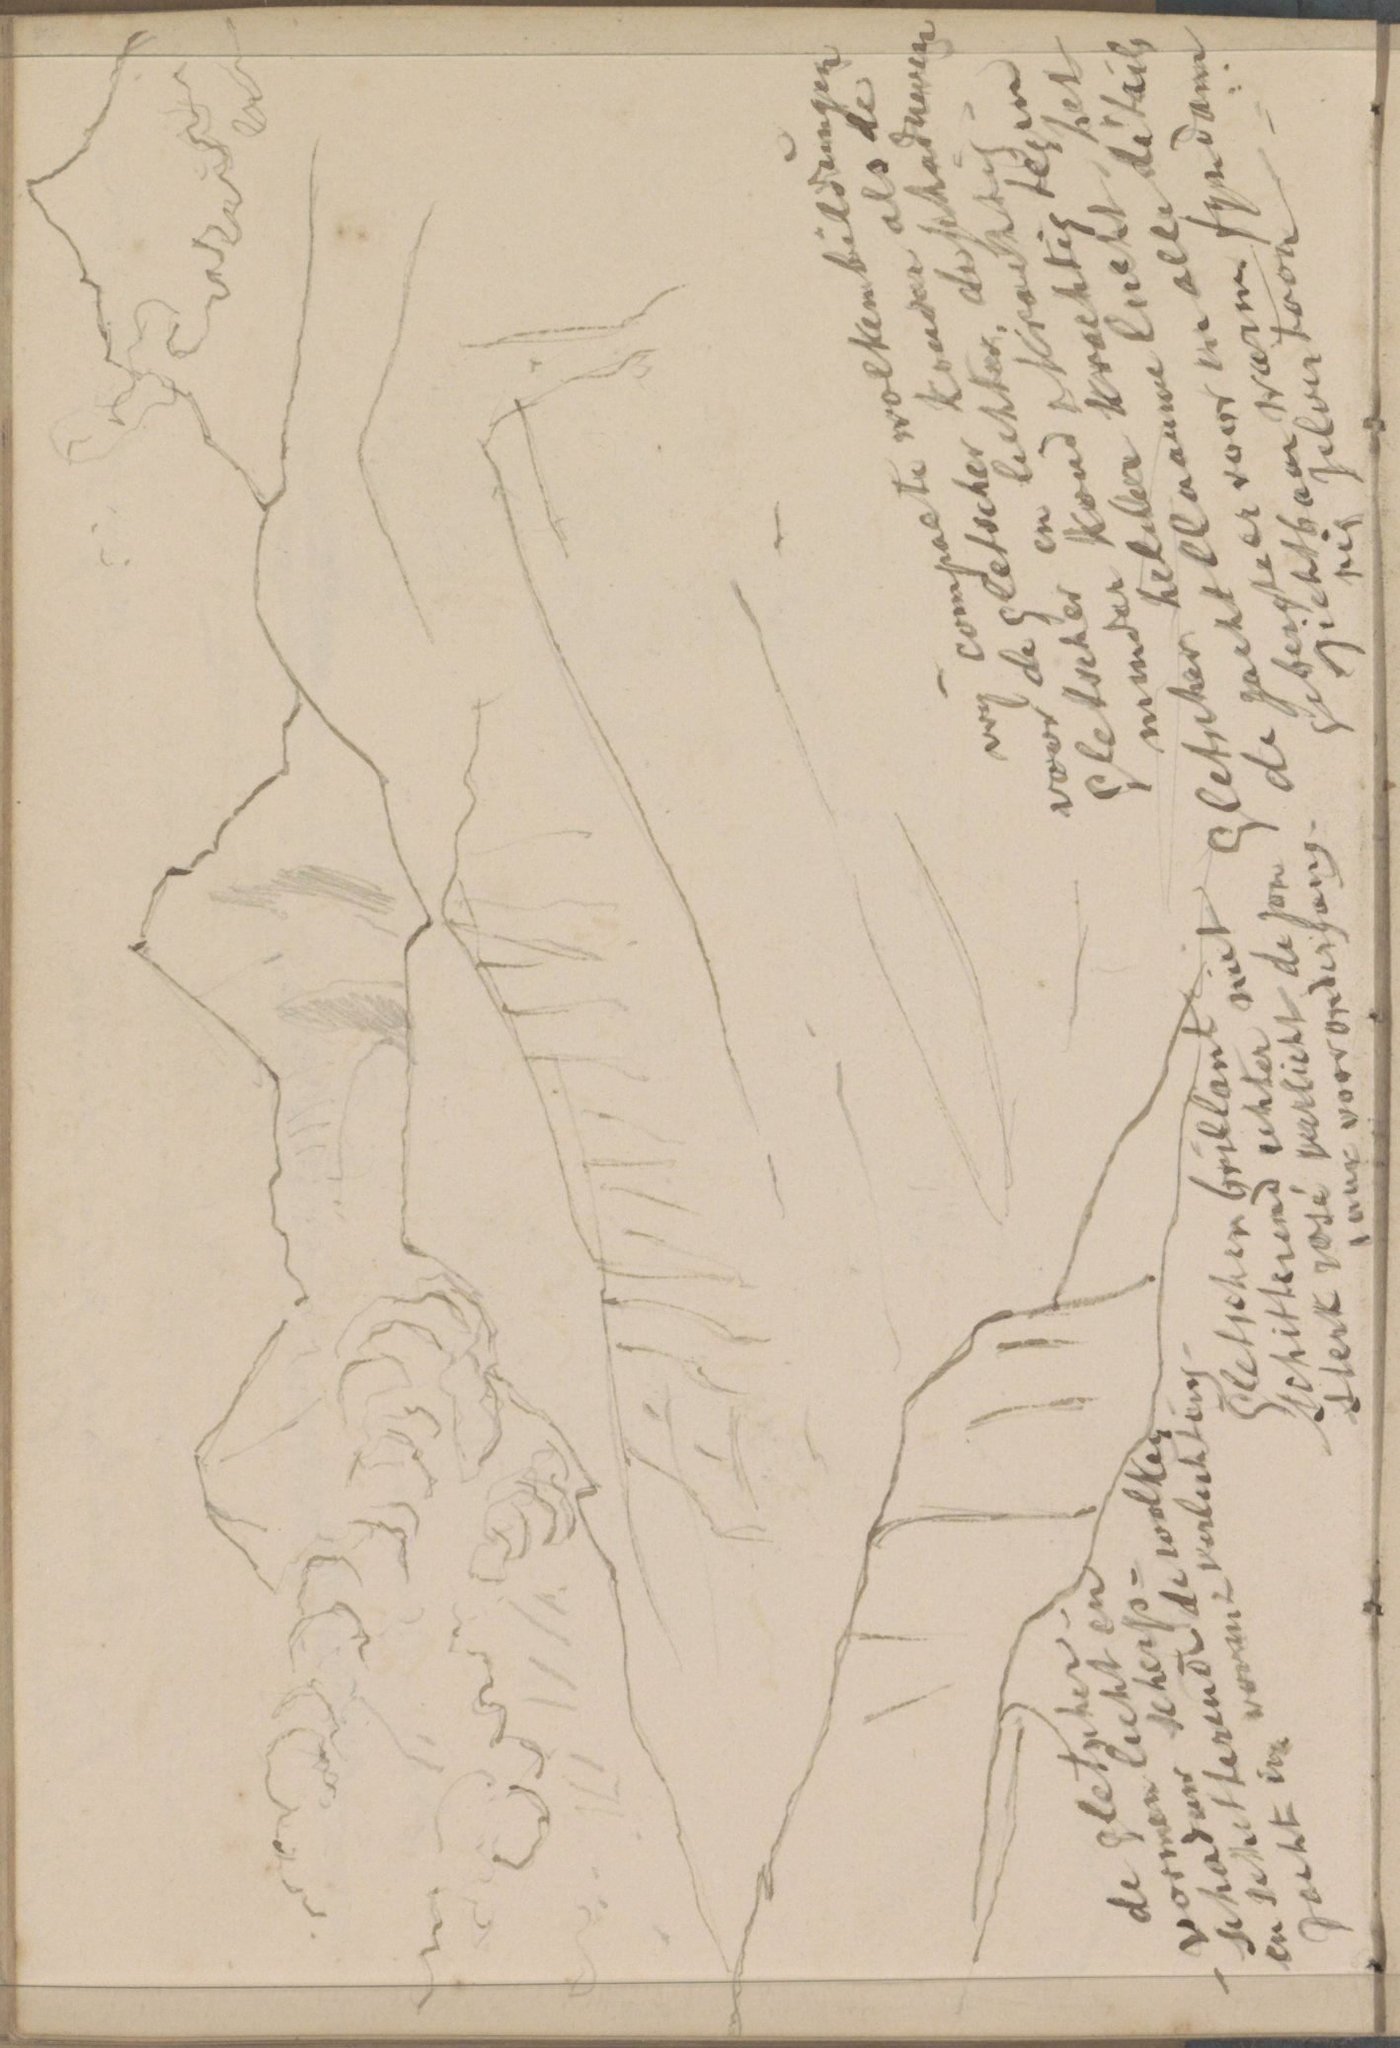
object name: sketchbook leaf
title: Wolken boven enkele gletsjers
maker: johannes tavenraat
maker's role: draughtsman, painter, print maker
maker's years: 1809-1881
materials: ink, paper, pencil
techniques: pen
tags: clouds, glacier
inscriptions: kleurnotitie, handgeschreven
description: Blad 42 verso uit een schetsboek met 47 bladen.